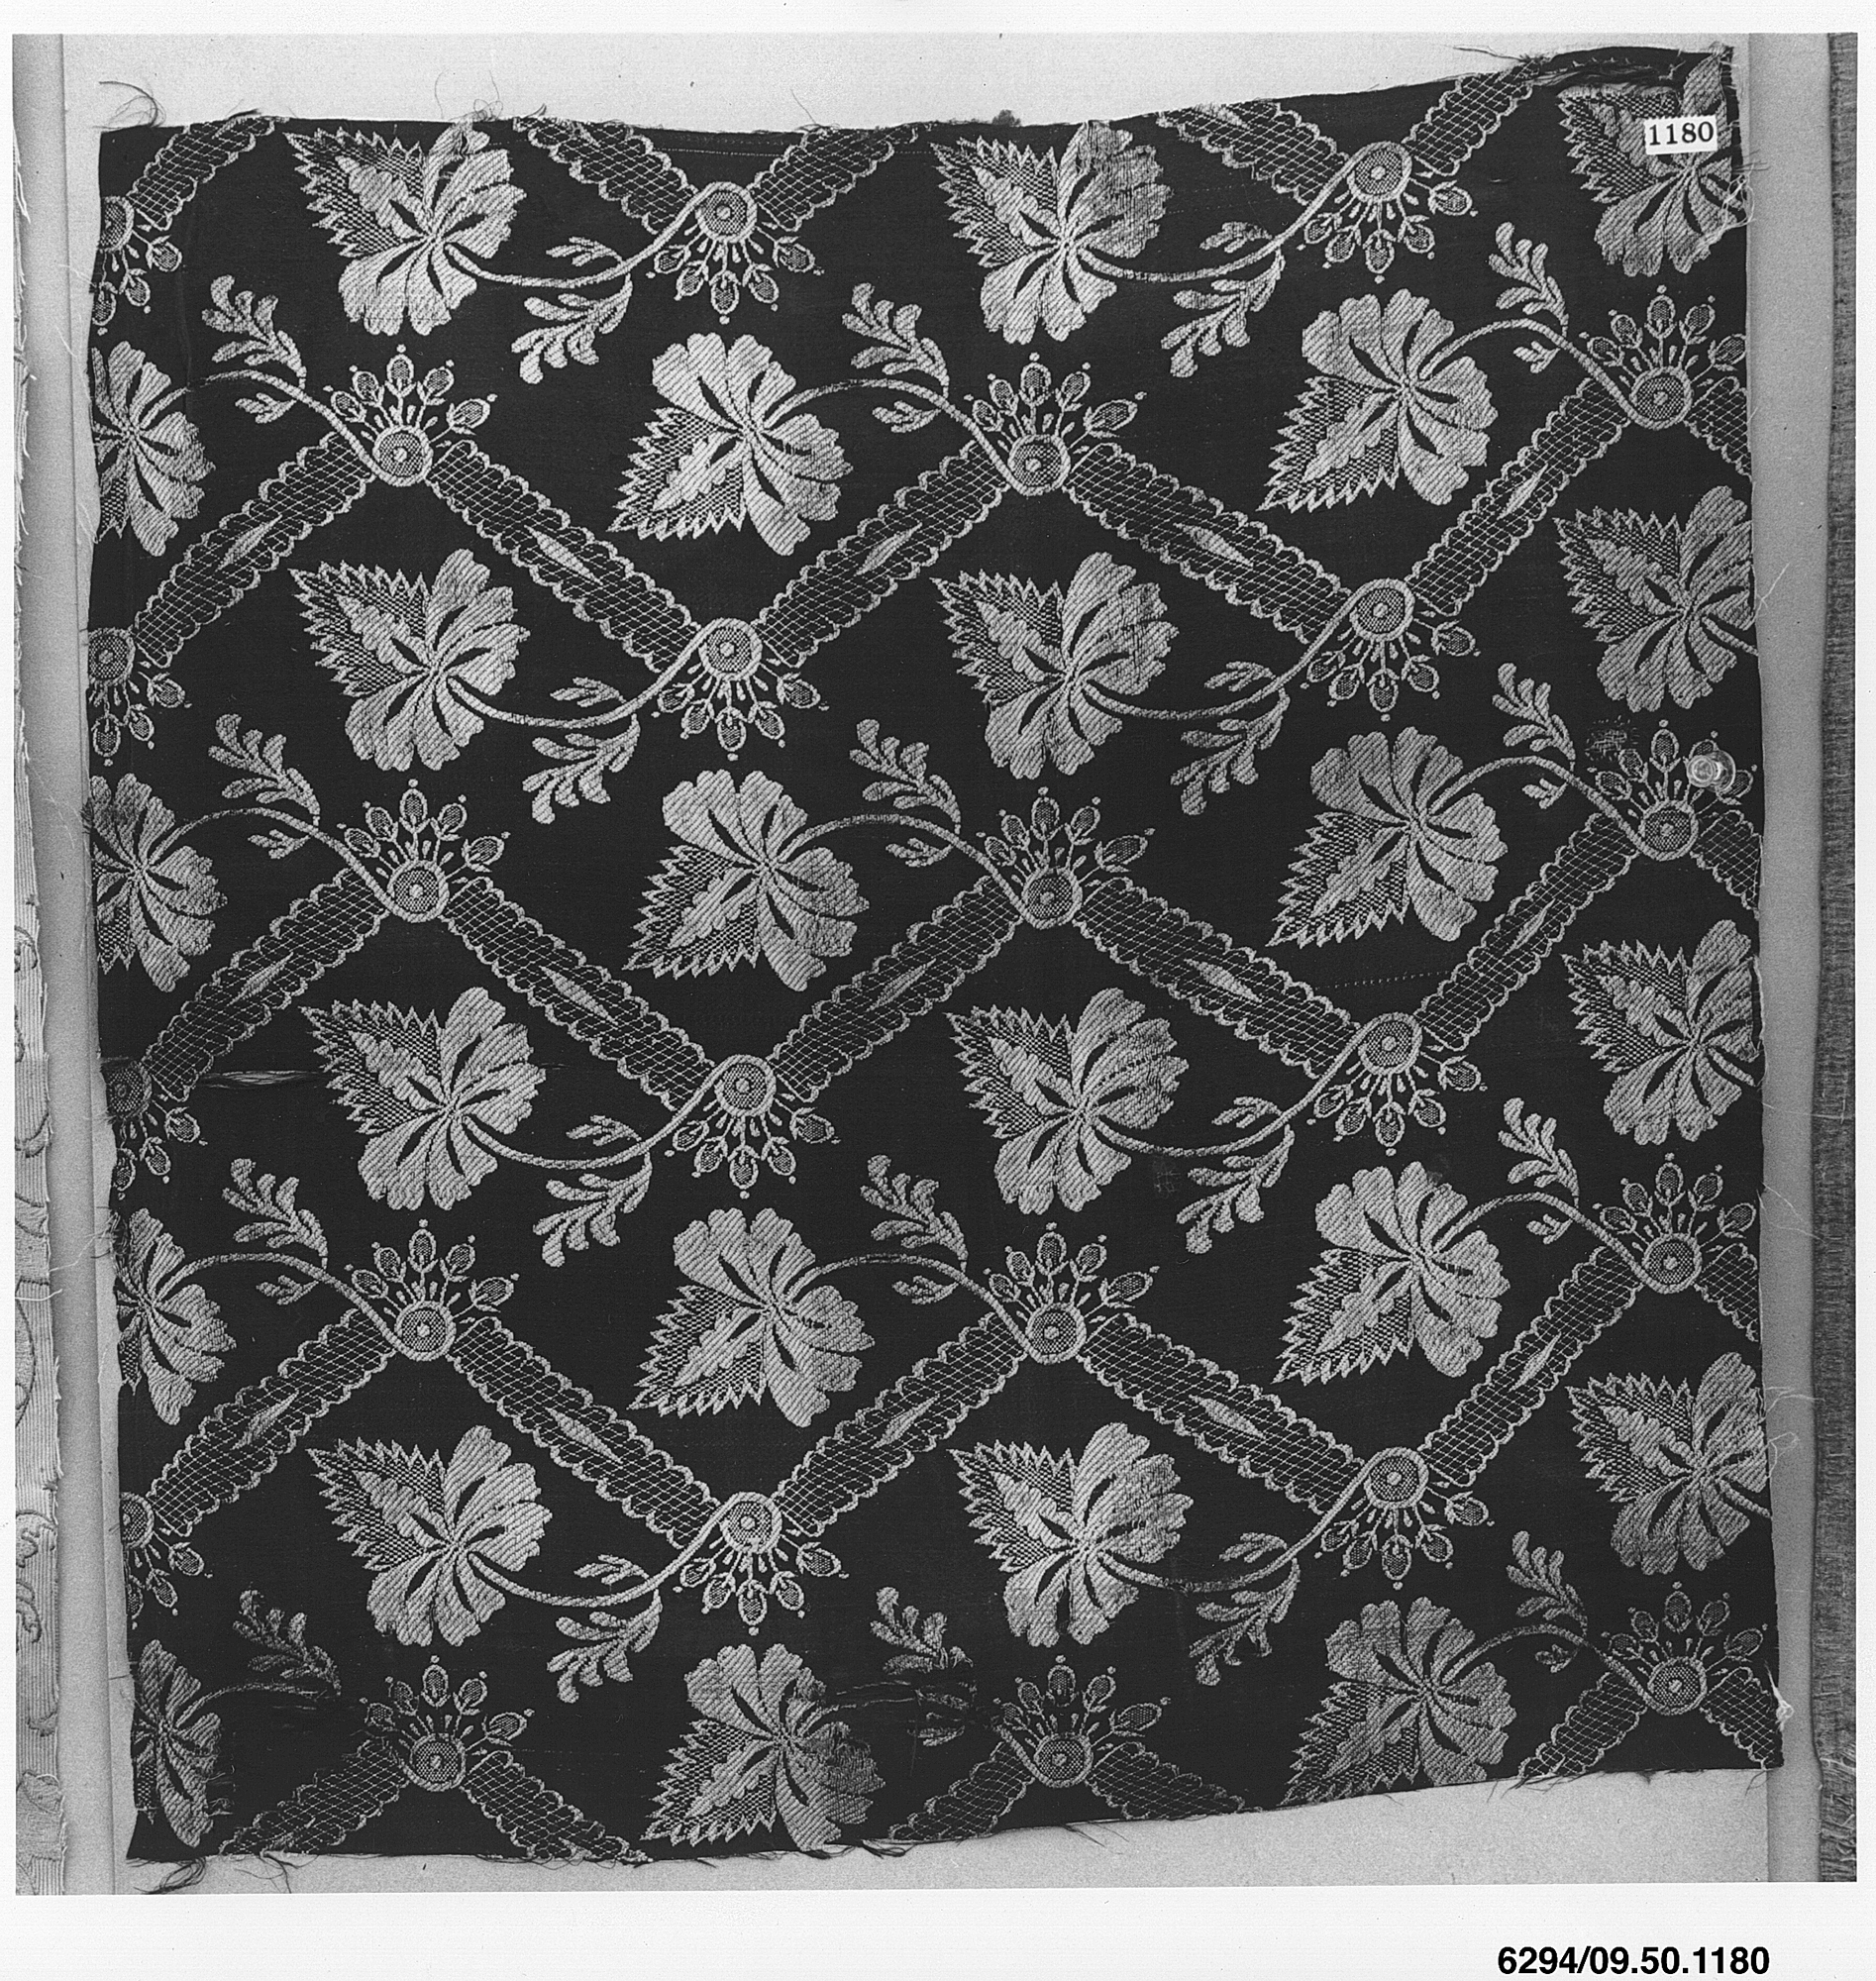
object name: piece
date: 1801-1900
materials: silk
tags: leaves